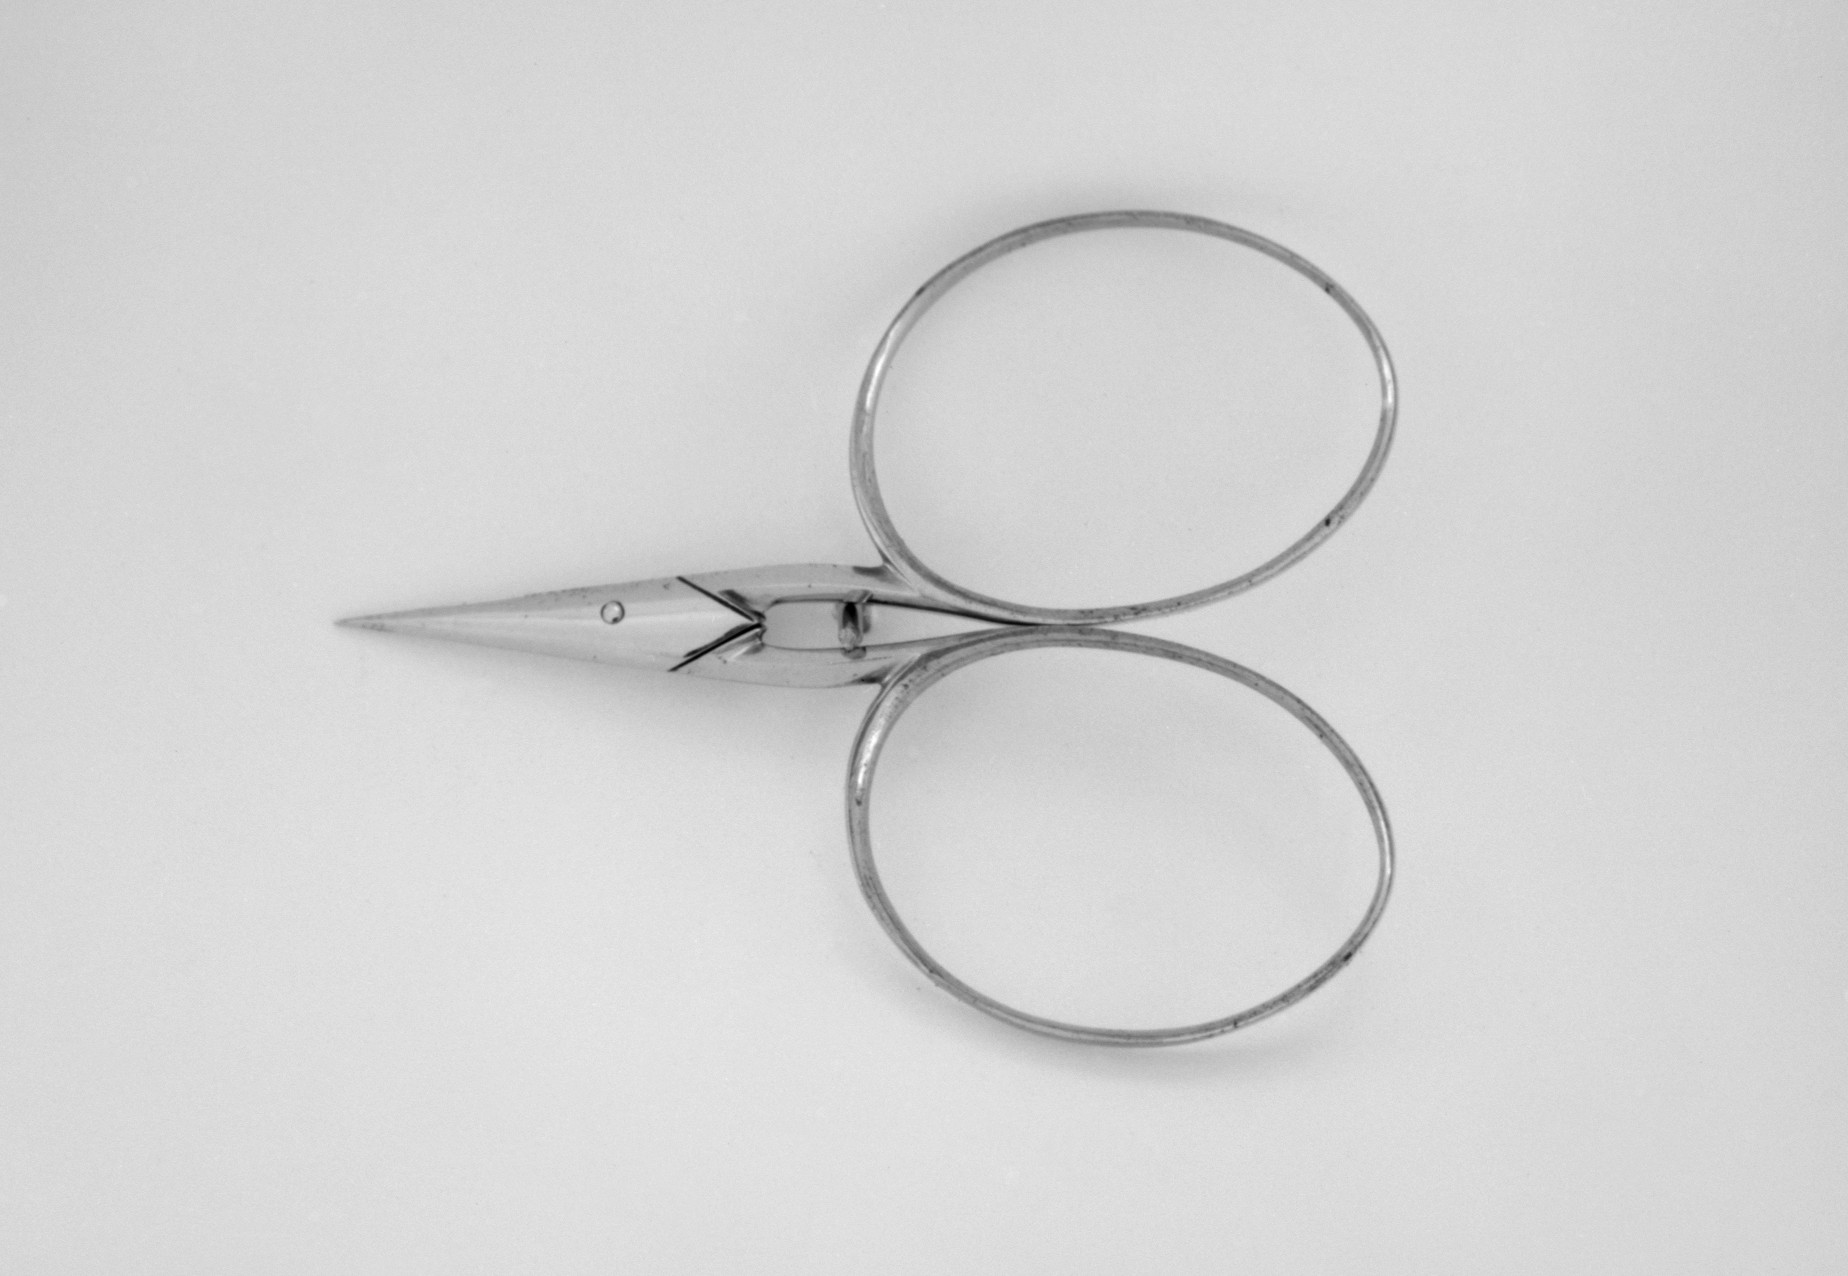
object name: scissors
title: Nose or mustache scissors (part of a set)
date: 1848-1849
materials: steel